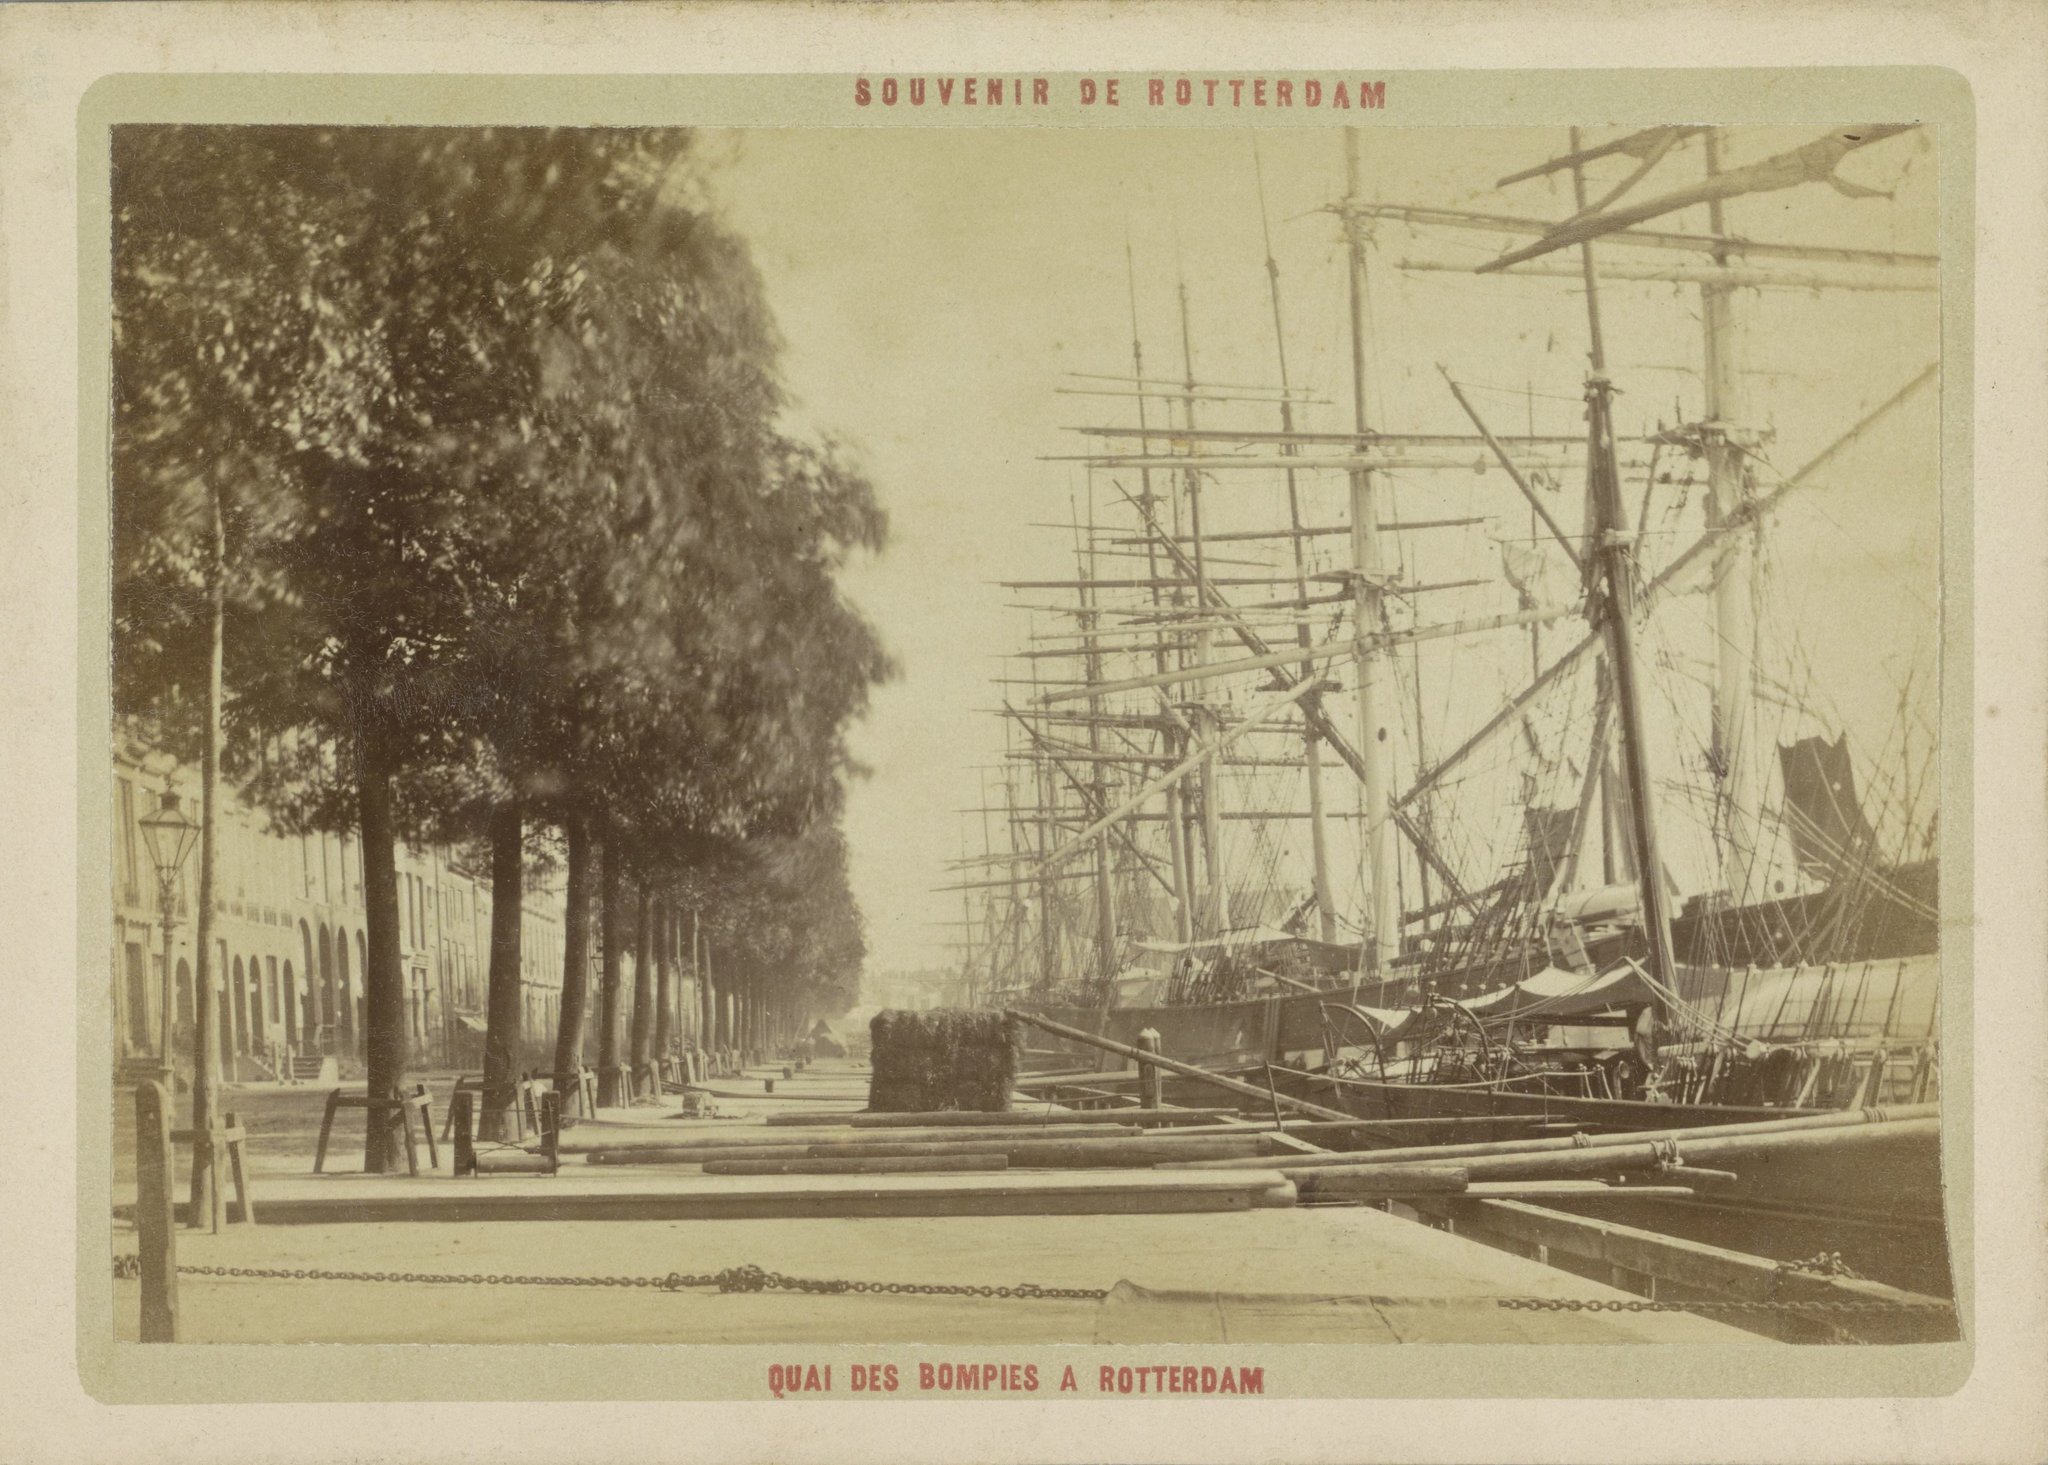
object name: cabinet photograph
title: Schepen aan de Boompjes te Rotterdam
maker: Anonymous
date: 1860-1880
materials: cardboard, photographic support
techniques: albumen print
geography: rotterdam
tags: sailing-ship, sailing-boat, quay (+ city(-scape) with figures, staffage)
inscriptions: inscription: ‘De Boompjes’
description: Onderdeel van Verzamelband met foto's van Rotterdam.